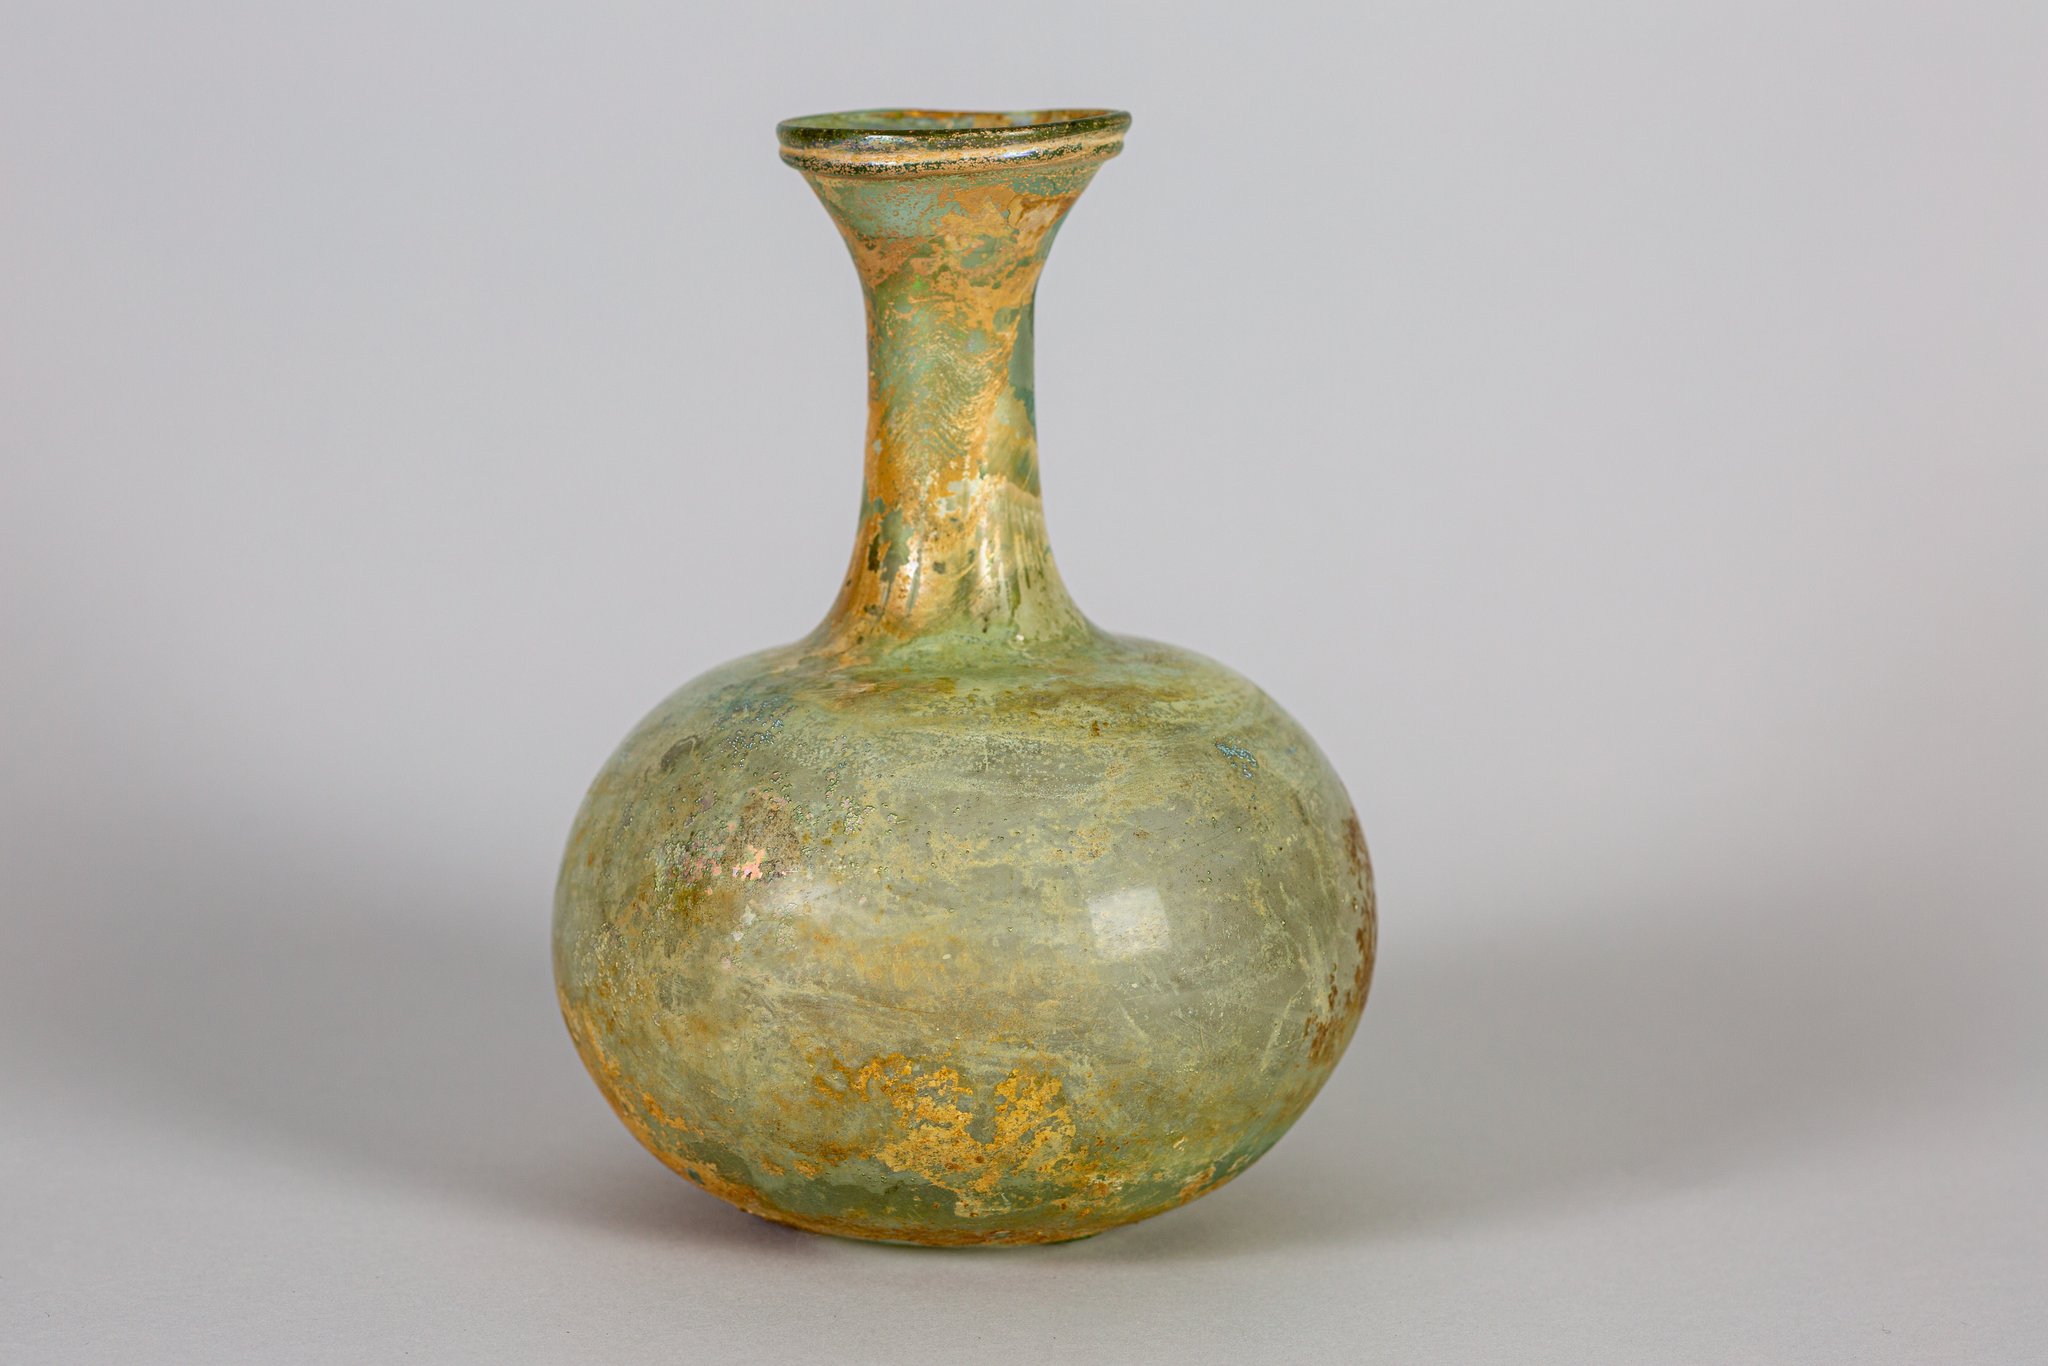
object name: flask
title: Glass flask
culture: roman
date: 301-400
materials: glass